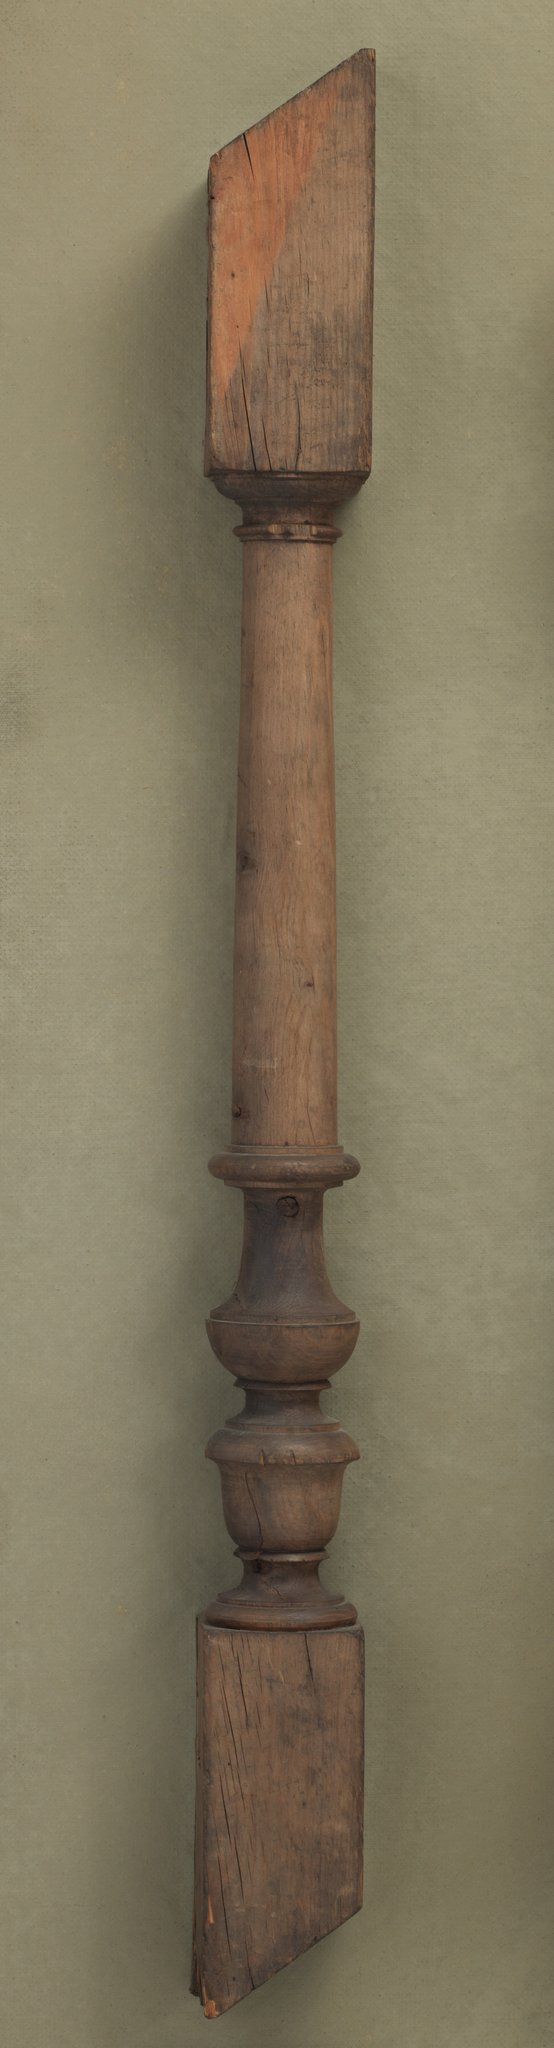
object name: baluster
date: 1667-1733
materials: wood